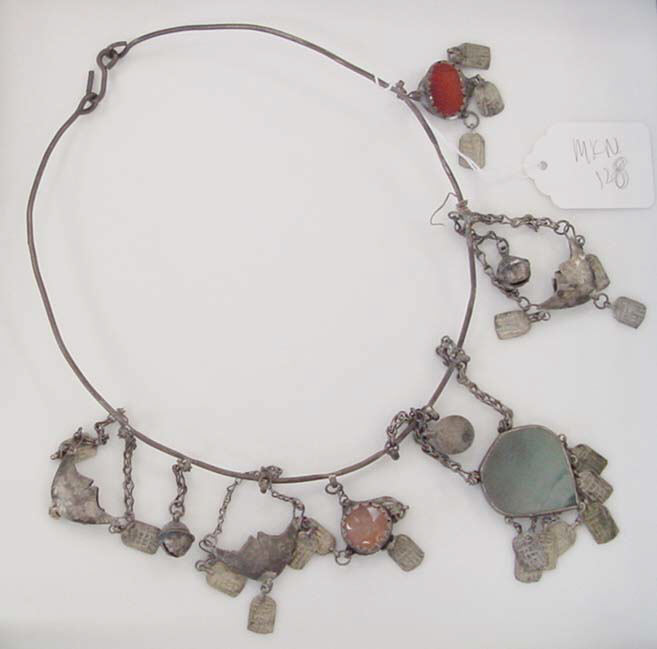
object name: necklace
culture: moroccan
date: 1801-1900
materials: metal, stone